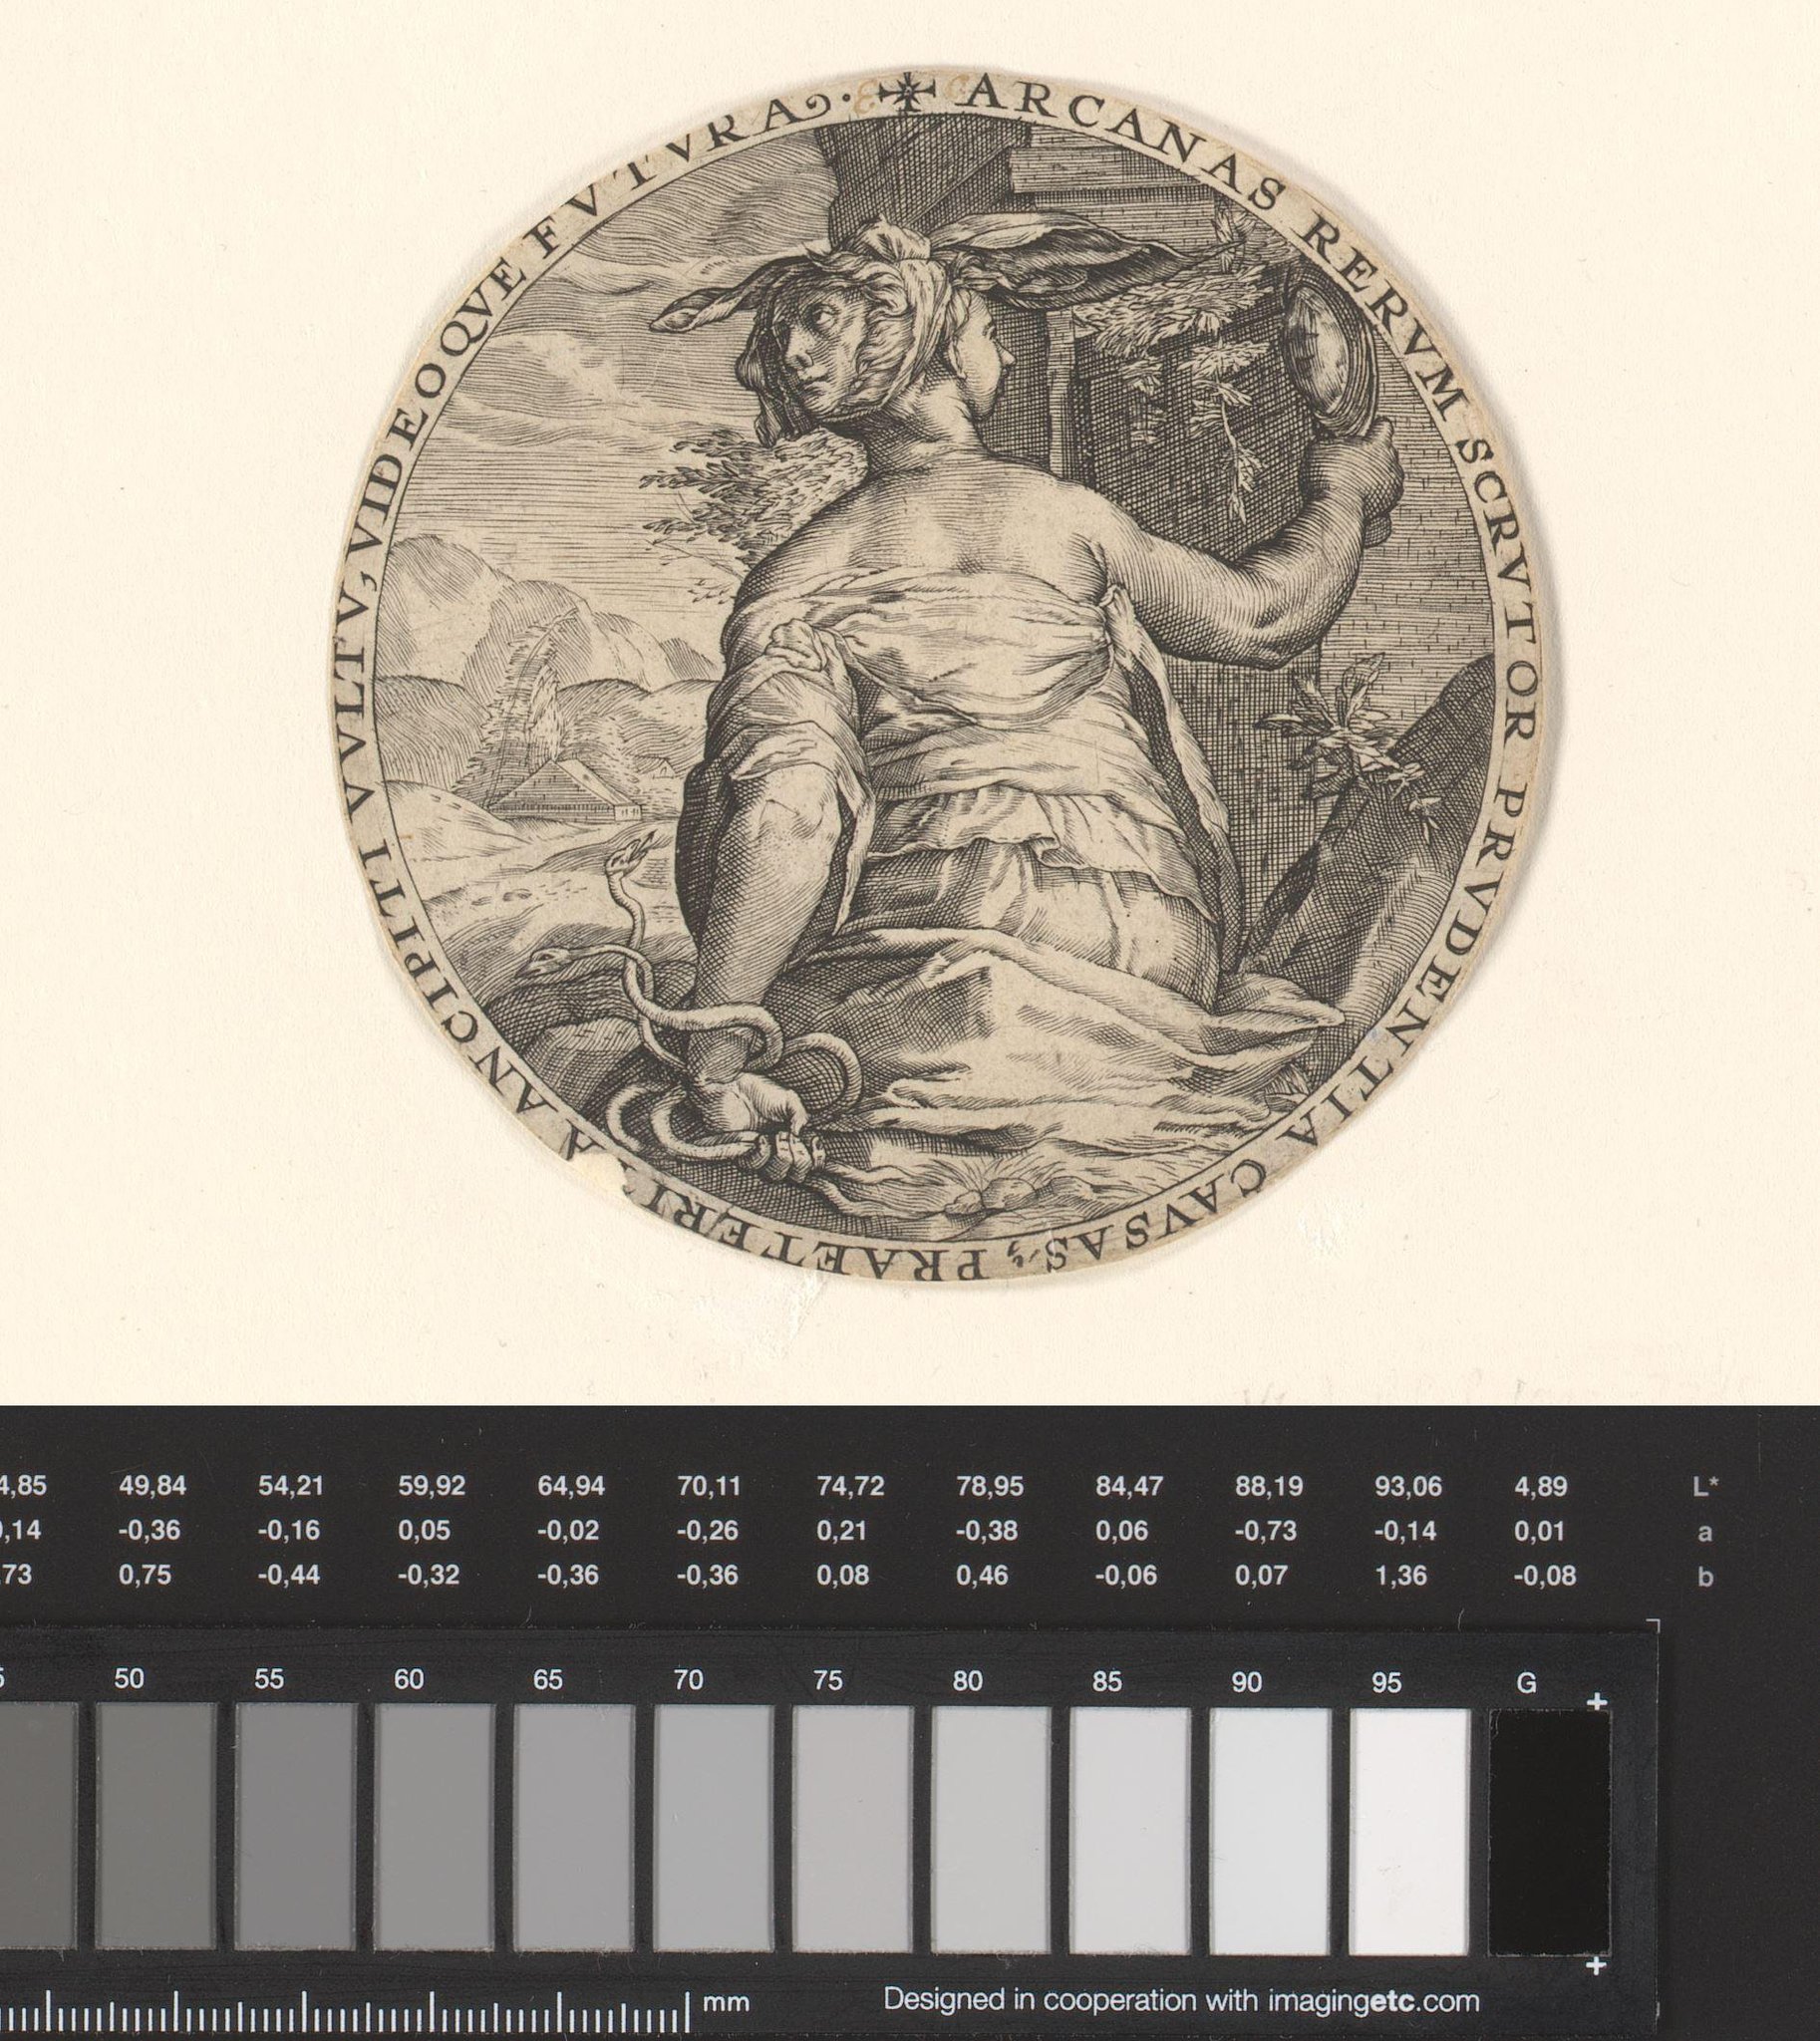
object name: print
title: Virtutu Theologicaru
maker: crispijn van de passe (i)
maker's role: draughtsman, print maker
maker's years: 1564-1637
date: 1600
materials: paper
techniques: engraving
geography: cologne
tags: prudence, 'prudentia'; 'prudenza' (ripa) ~ one of the four cardinal virtues, janus' head, two-faced head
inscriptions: monogram: ‘EC’